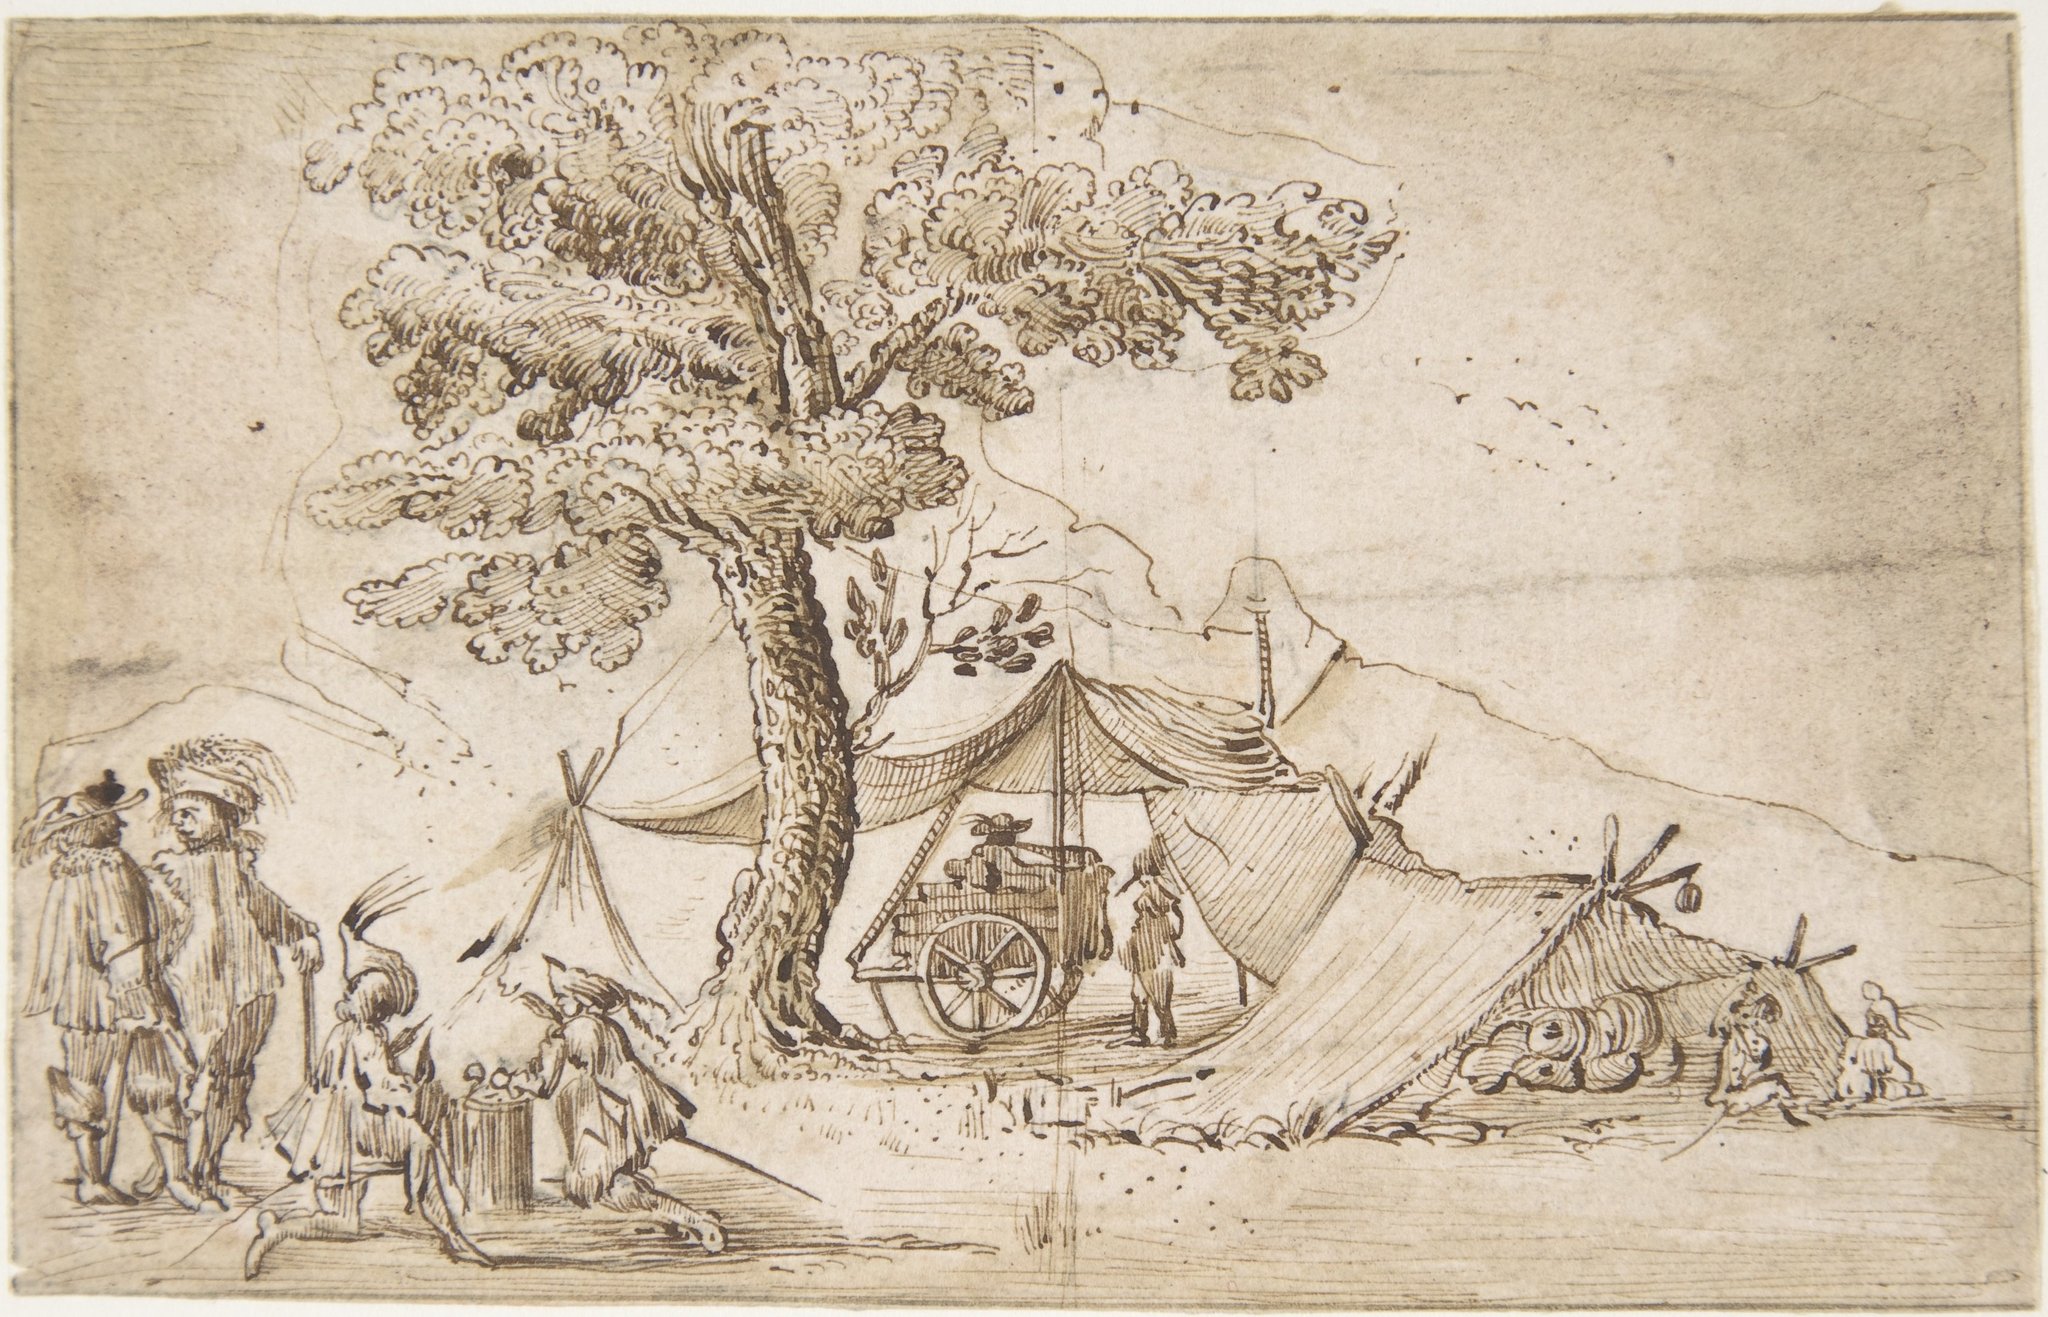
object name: drawing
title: A Bivouac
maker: jacques callot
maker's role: artist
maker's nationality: french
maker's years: 1592-1635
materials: ink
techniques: pen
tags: human figures,tents,trees